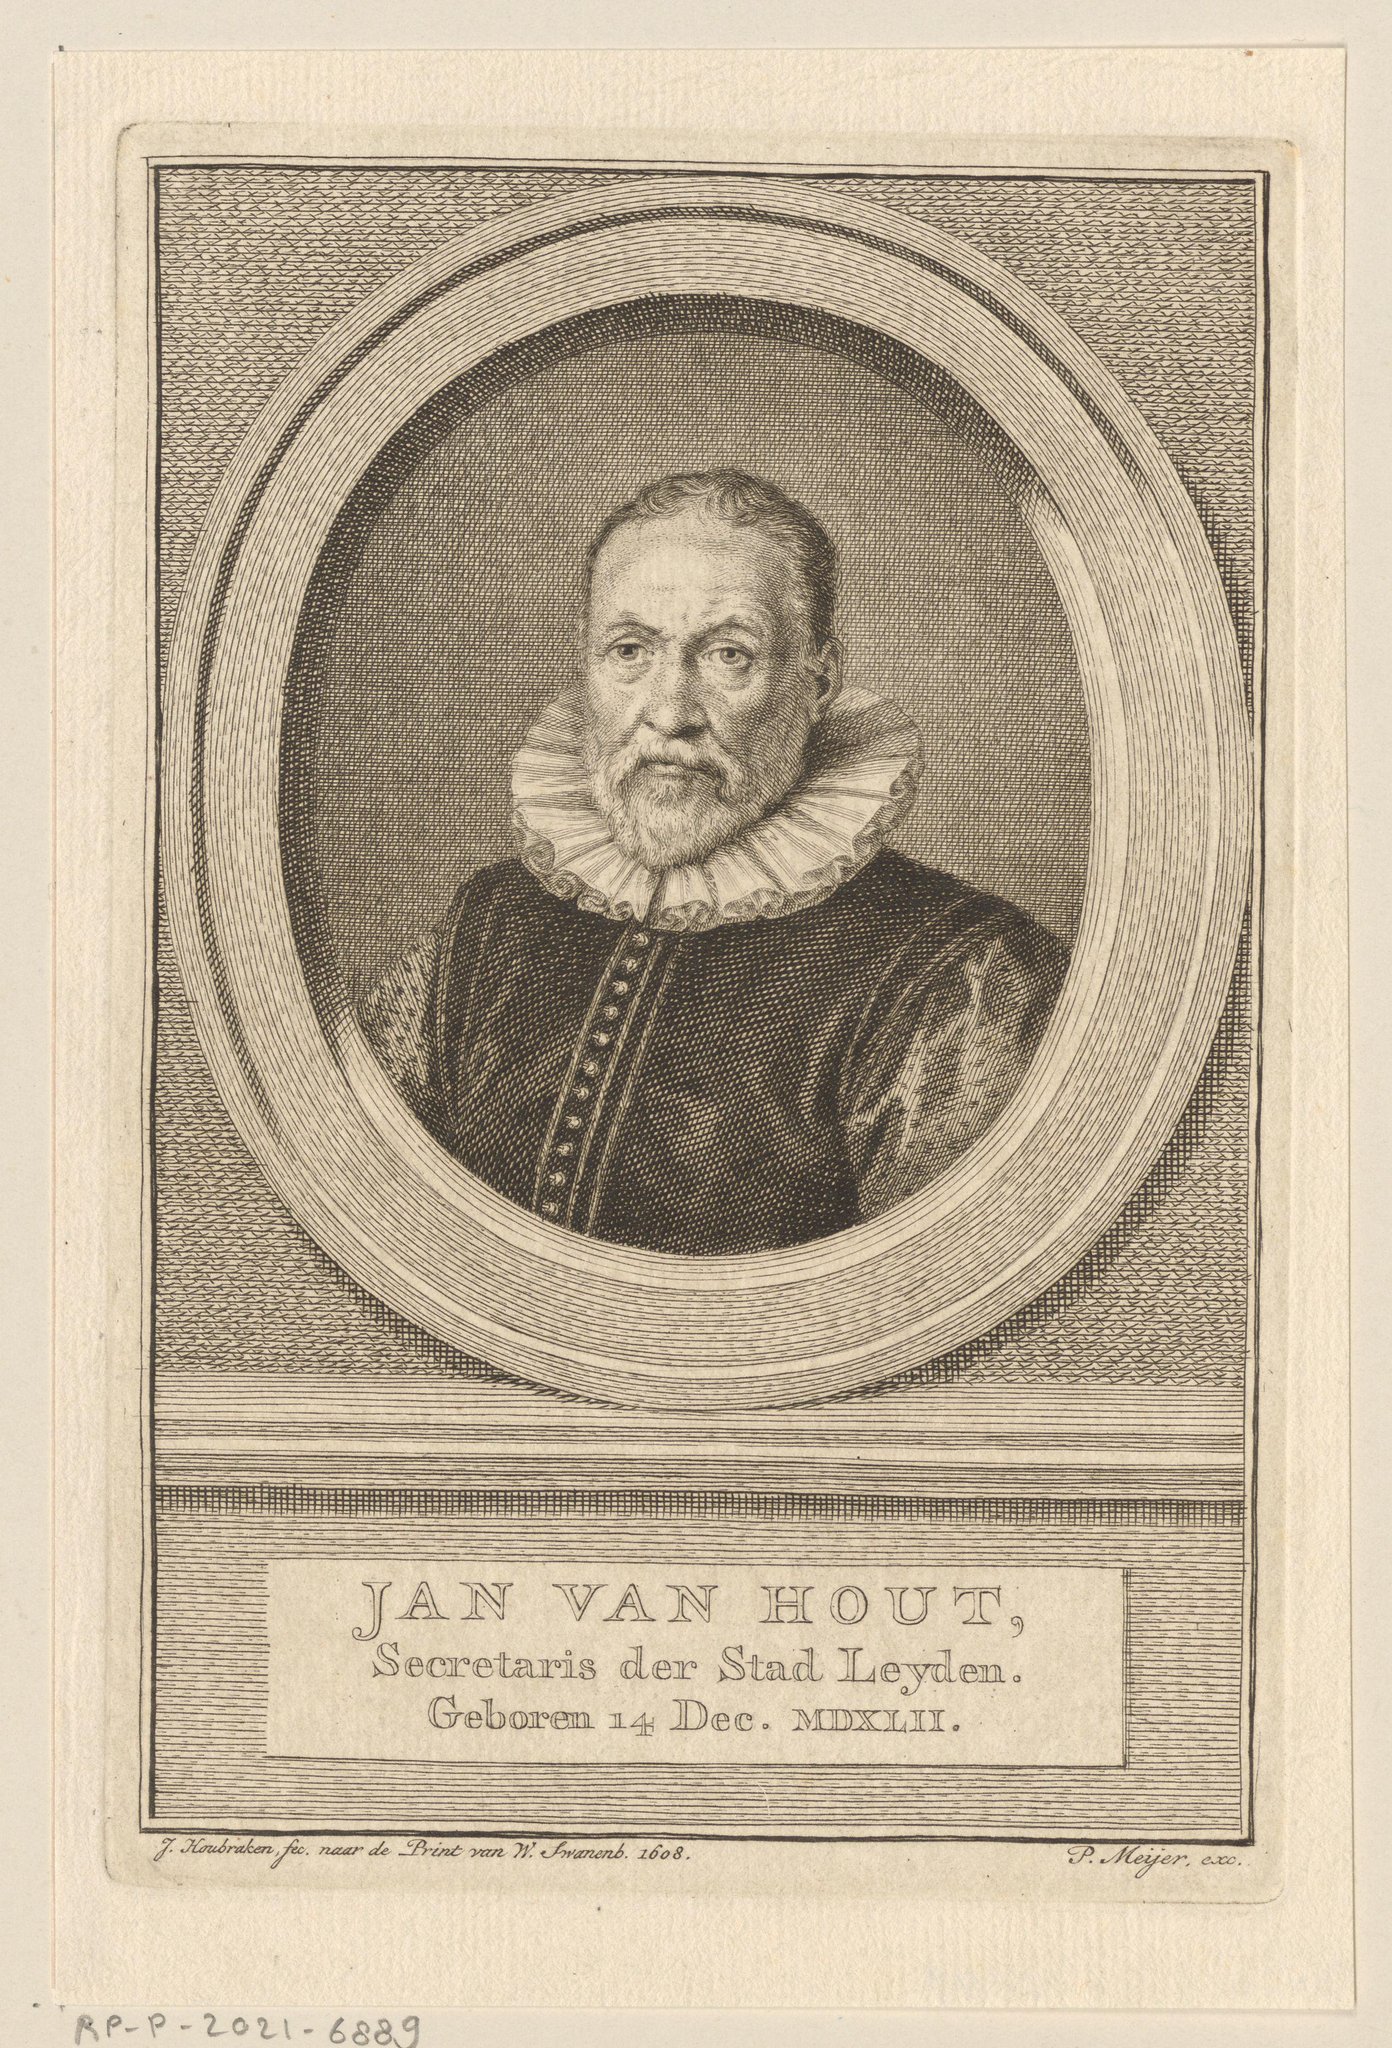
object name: print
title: Portret van Jan van Hout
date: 1747-1780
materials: paper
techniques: engraving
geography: amsterdam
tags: historical persons, portrait of a writer